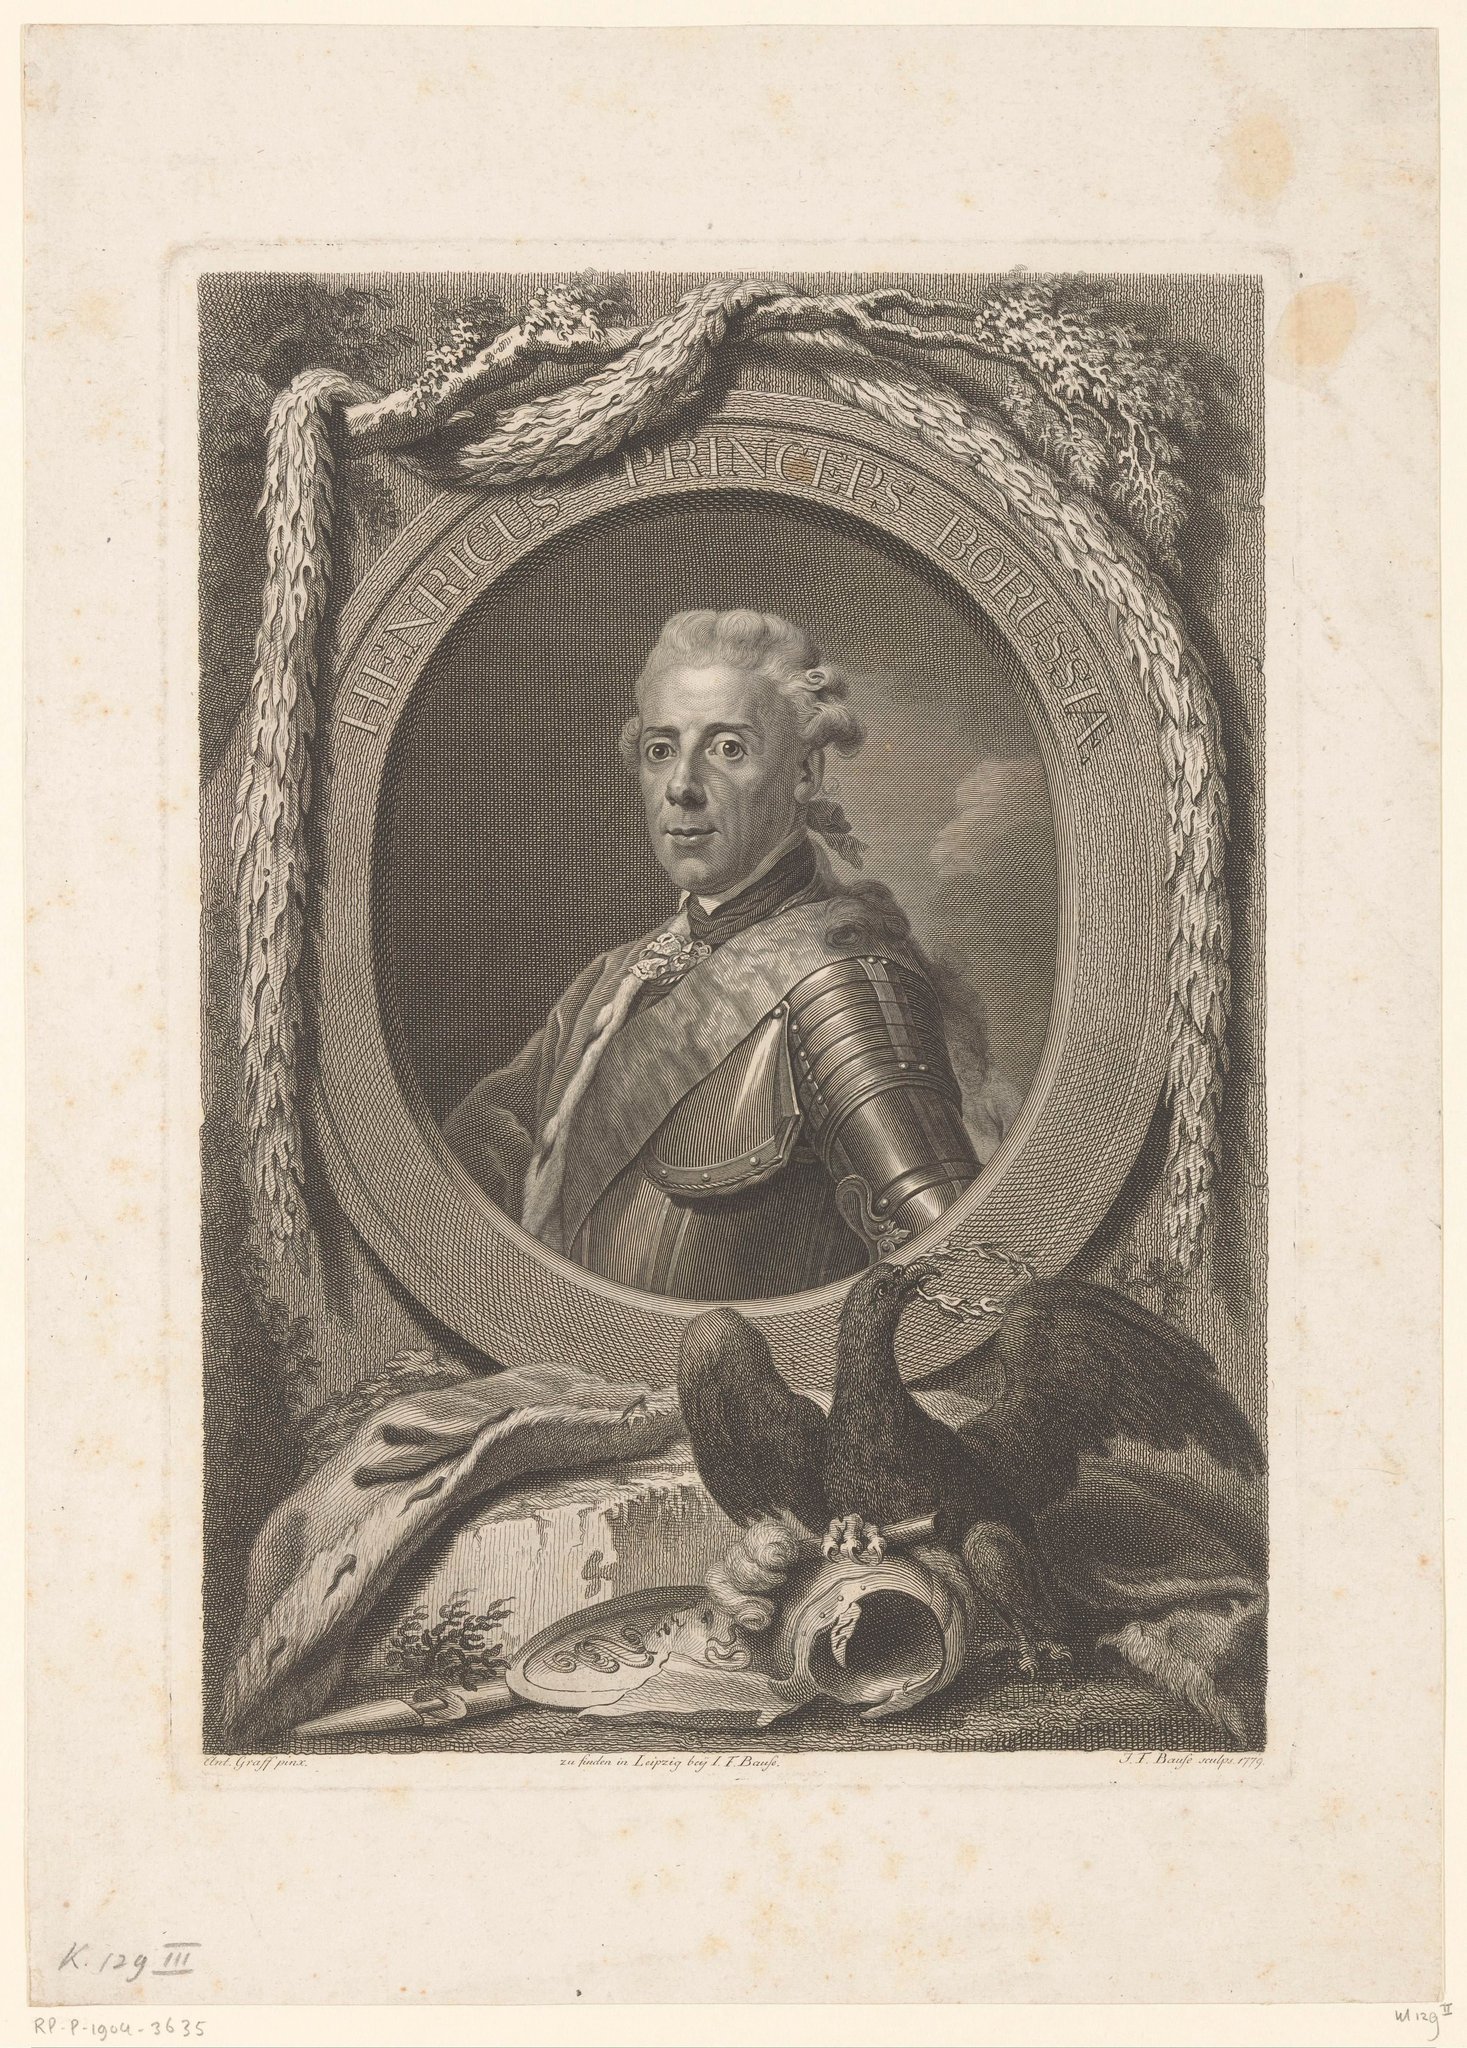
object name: print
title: Portret van Hendrik van Pruisen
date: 1779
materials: paper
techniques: engraving, etching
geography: leipzig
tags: berlin, friedrich heinrich ludwig van pruisen, armour, historical persons, predatory birds: eagle (+ heraldic animals), royal mantle (symbol of sovereignty)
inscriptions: collector's mark: Lugt 2228